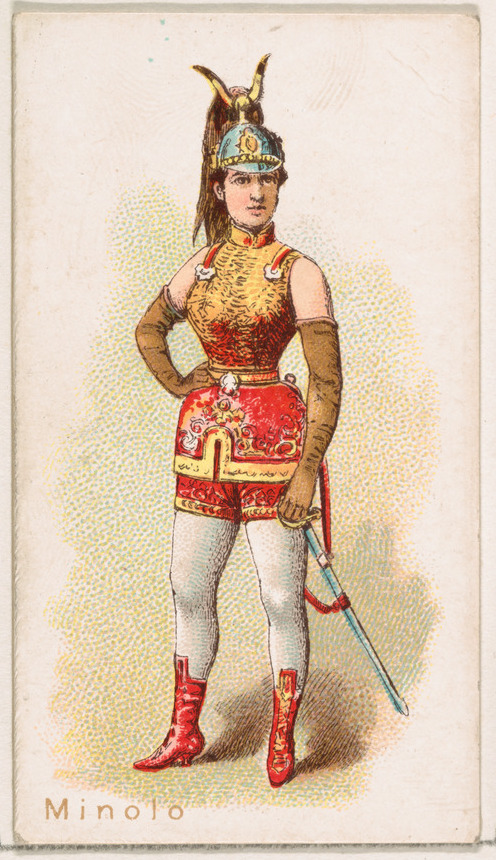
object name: print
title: Minolo, from the Ballet Queens series (N182) issued by Wm. S. Kimball & Co.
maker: william s. kimball & company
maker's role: publisher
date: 1889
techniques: color lithograph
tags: women